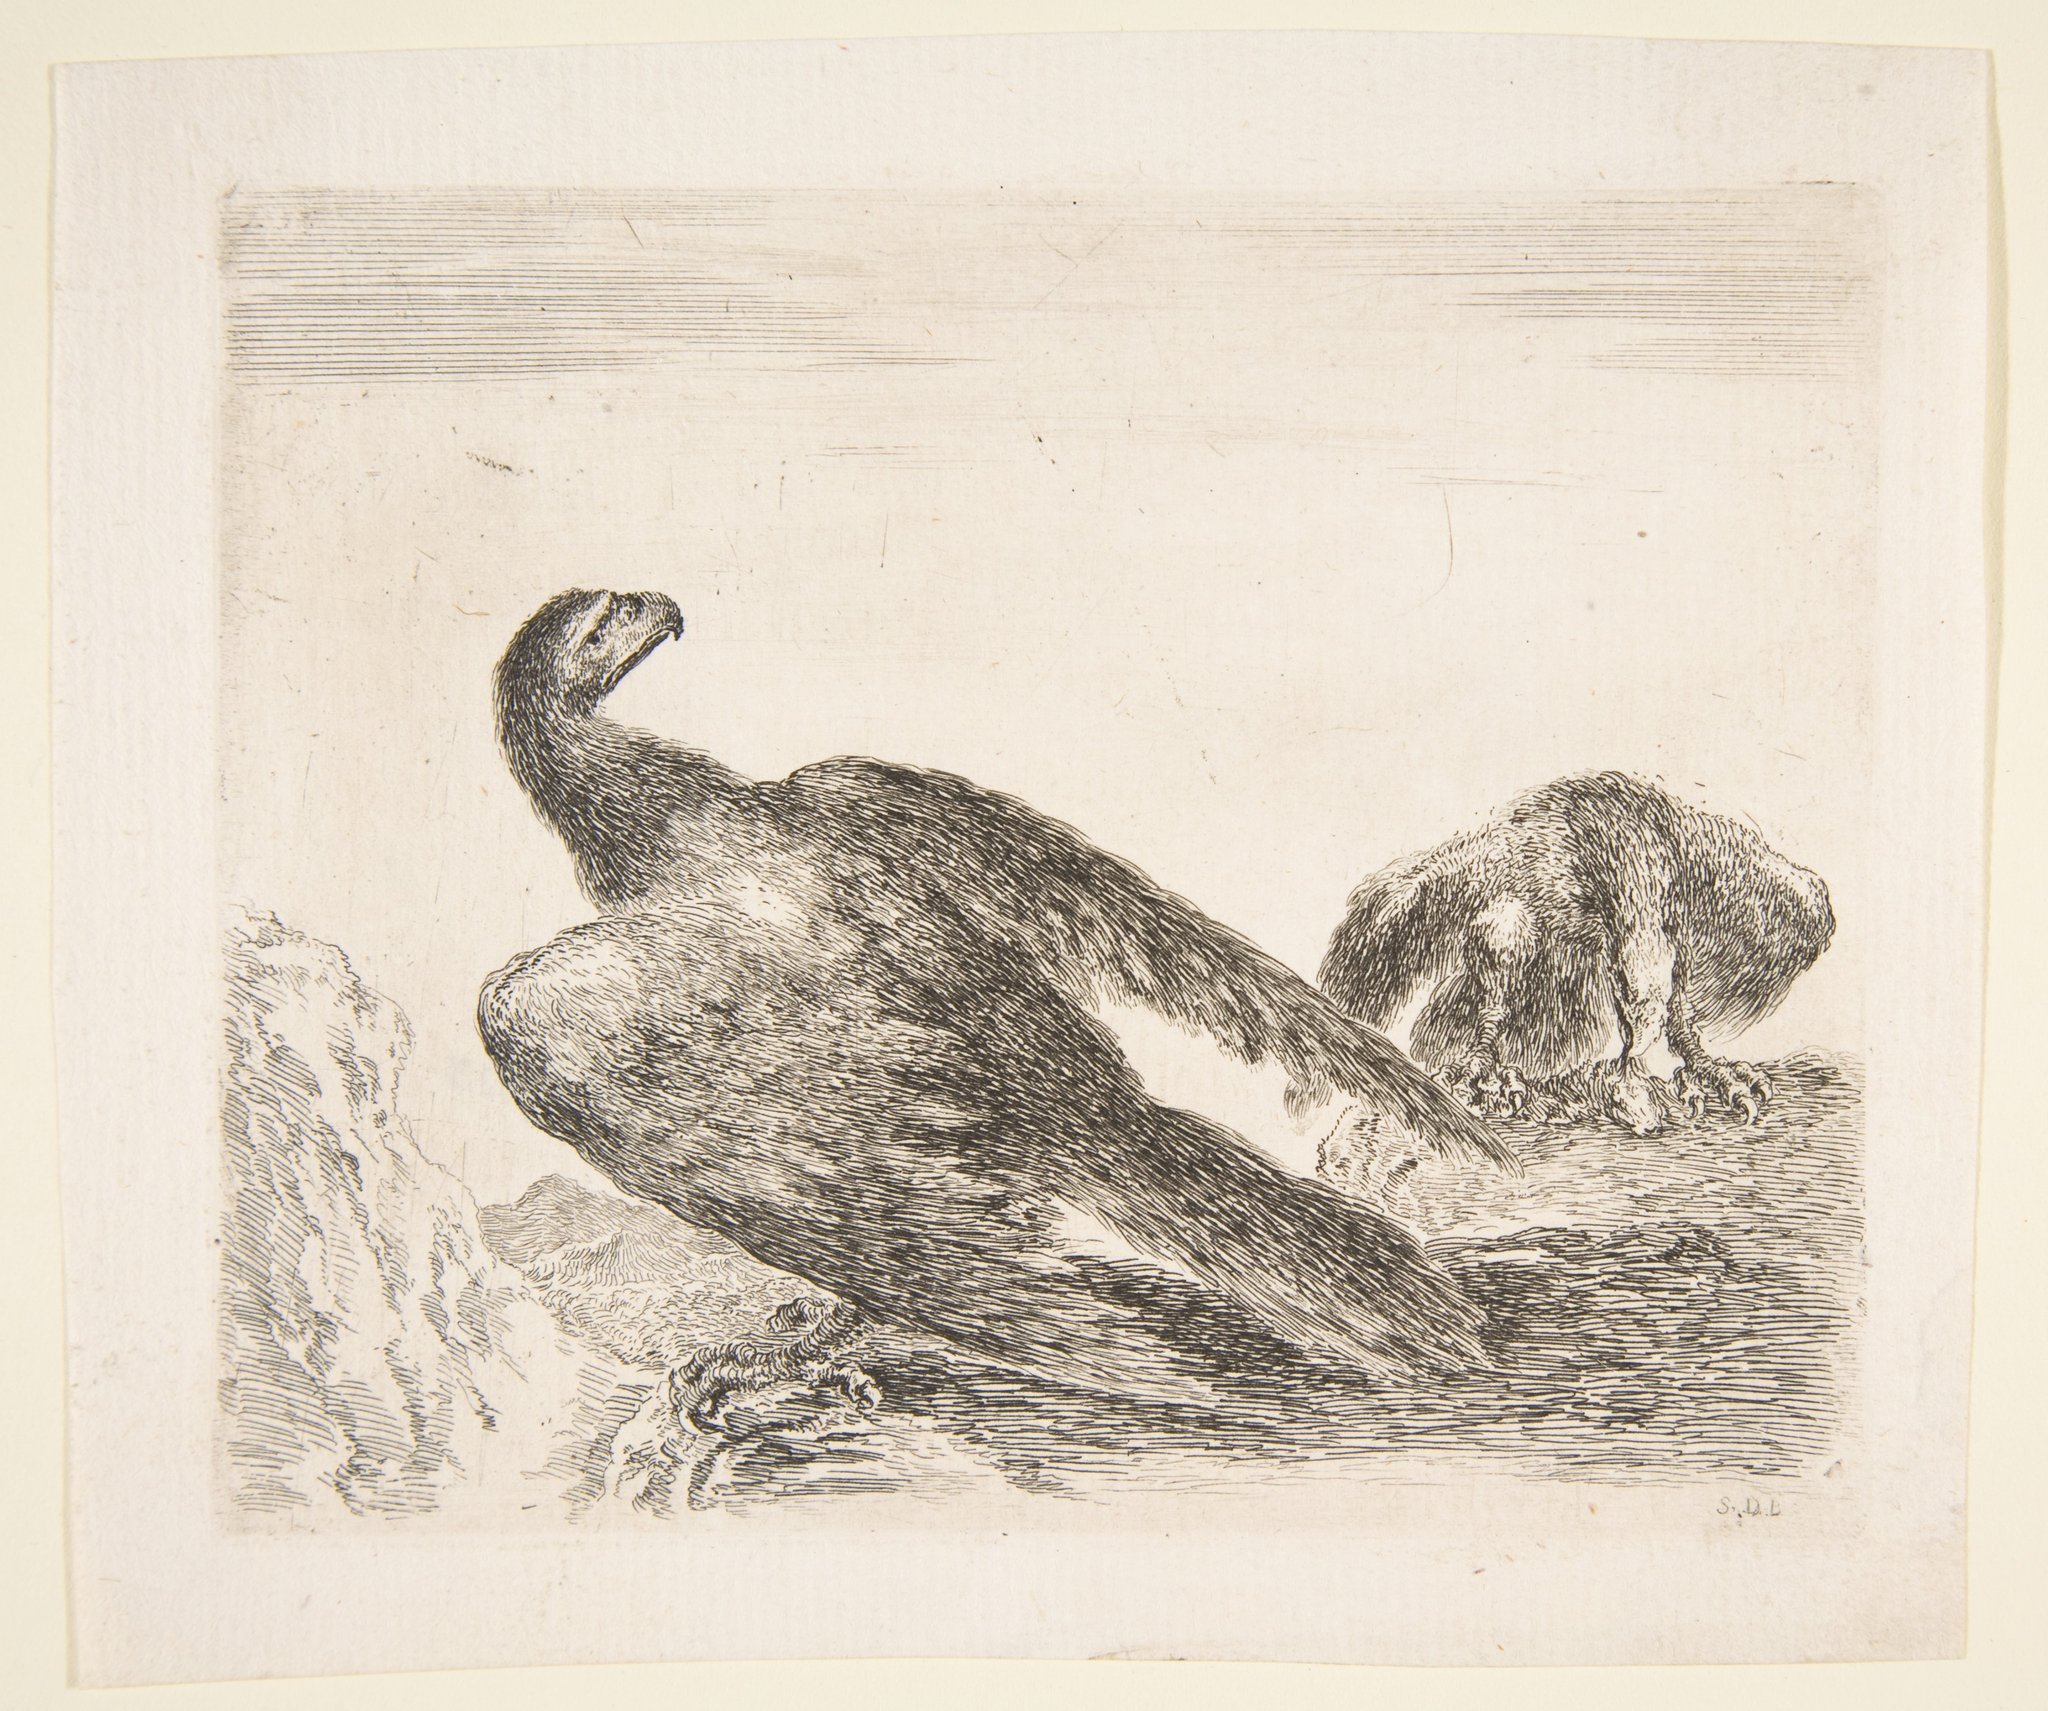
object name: print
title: Two eagles, one with prey, from 'Eagles' (Les aigles)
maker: stefano della bella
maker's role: artist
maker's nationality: italian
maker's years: 1610-1664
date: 1651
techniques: etching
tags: eagles